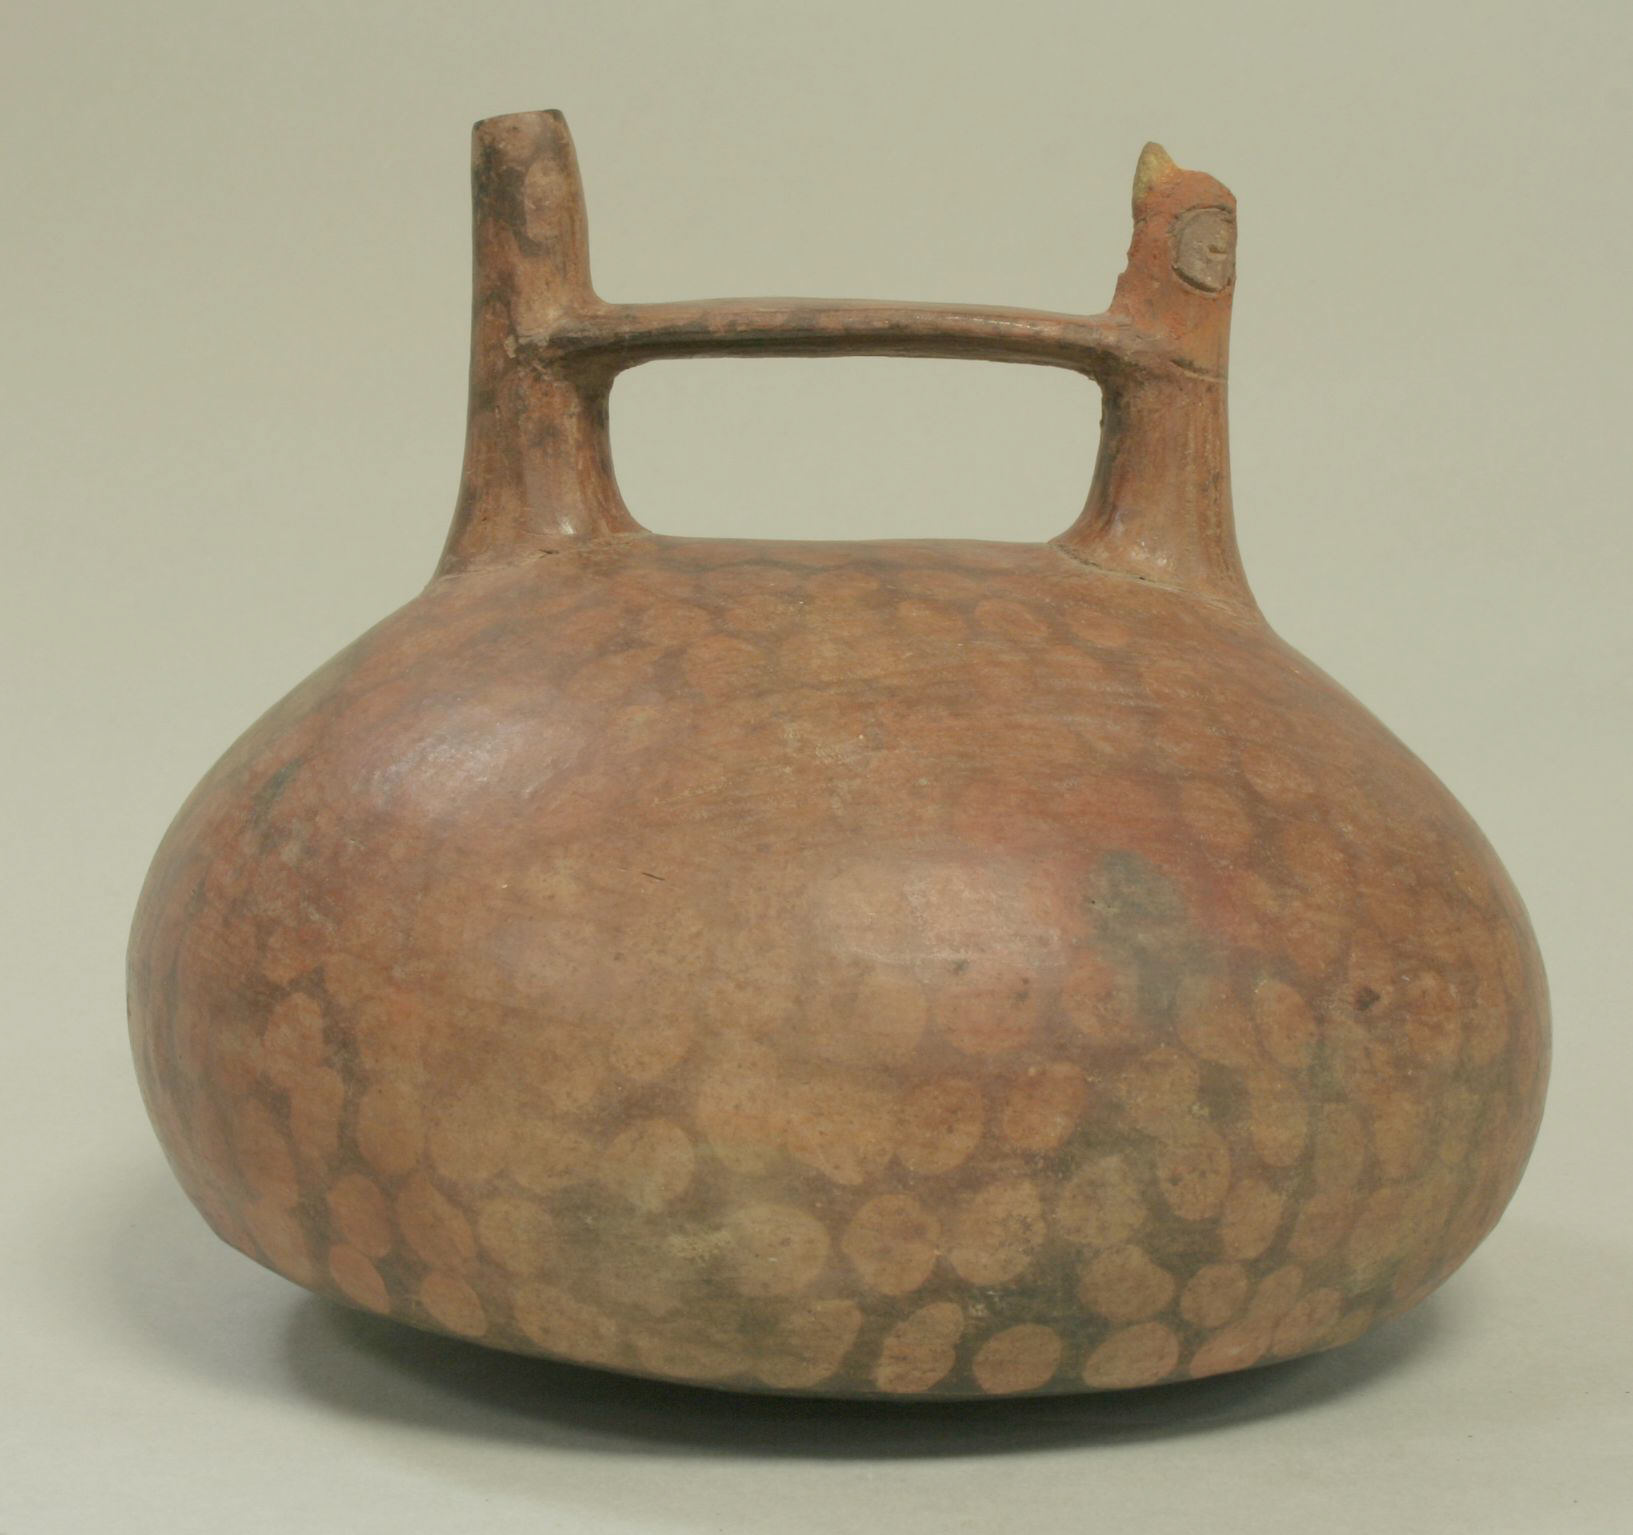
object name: bottle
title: Double Spout and Bridge Bottle with Bird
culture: paracas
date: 500-101 BCE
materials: ceramic, pigment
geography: peru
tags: birds